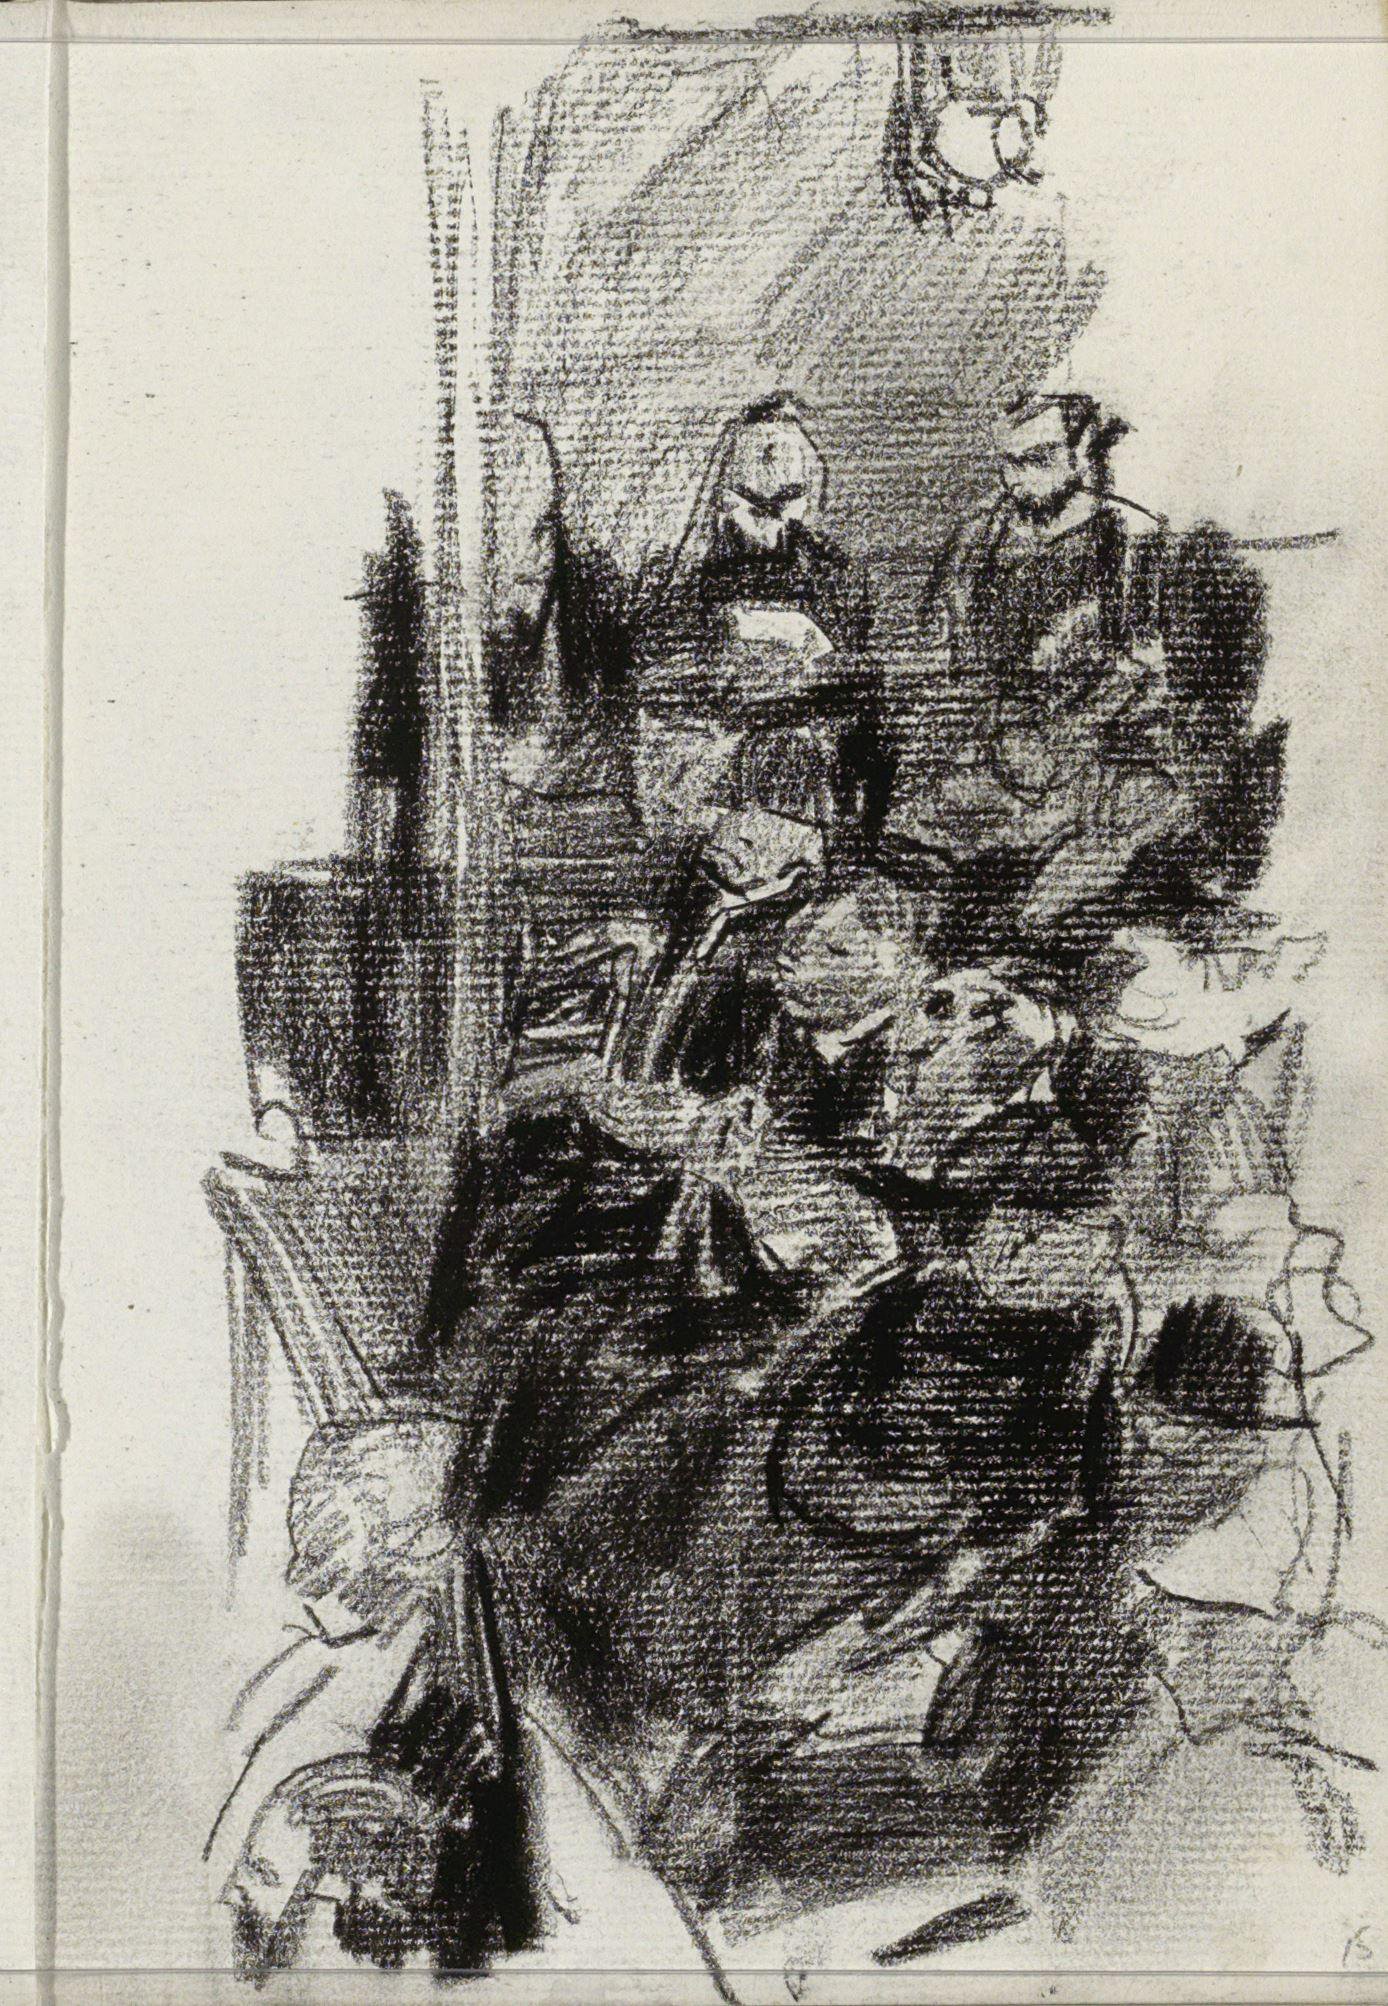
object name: sketchbook leaf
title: Zaal met publiek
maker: isaac israels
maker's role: draughtsman, painter, print maker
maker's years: 1865-1934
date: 1886-1903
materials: chalk, paper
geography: amsterdam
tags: the audience ~ art performance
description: Mogelijk in Carré. Pagina 15 uit schetsboek XXXVII met 52 pagina's.